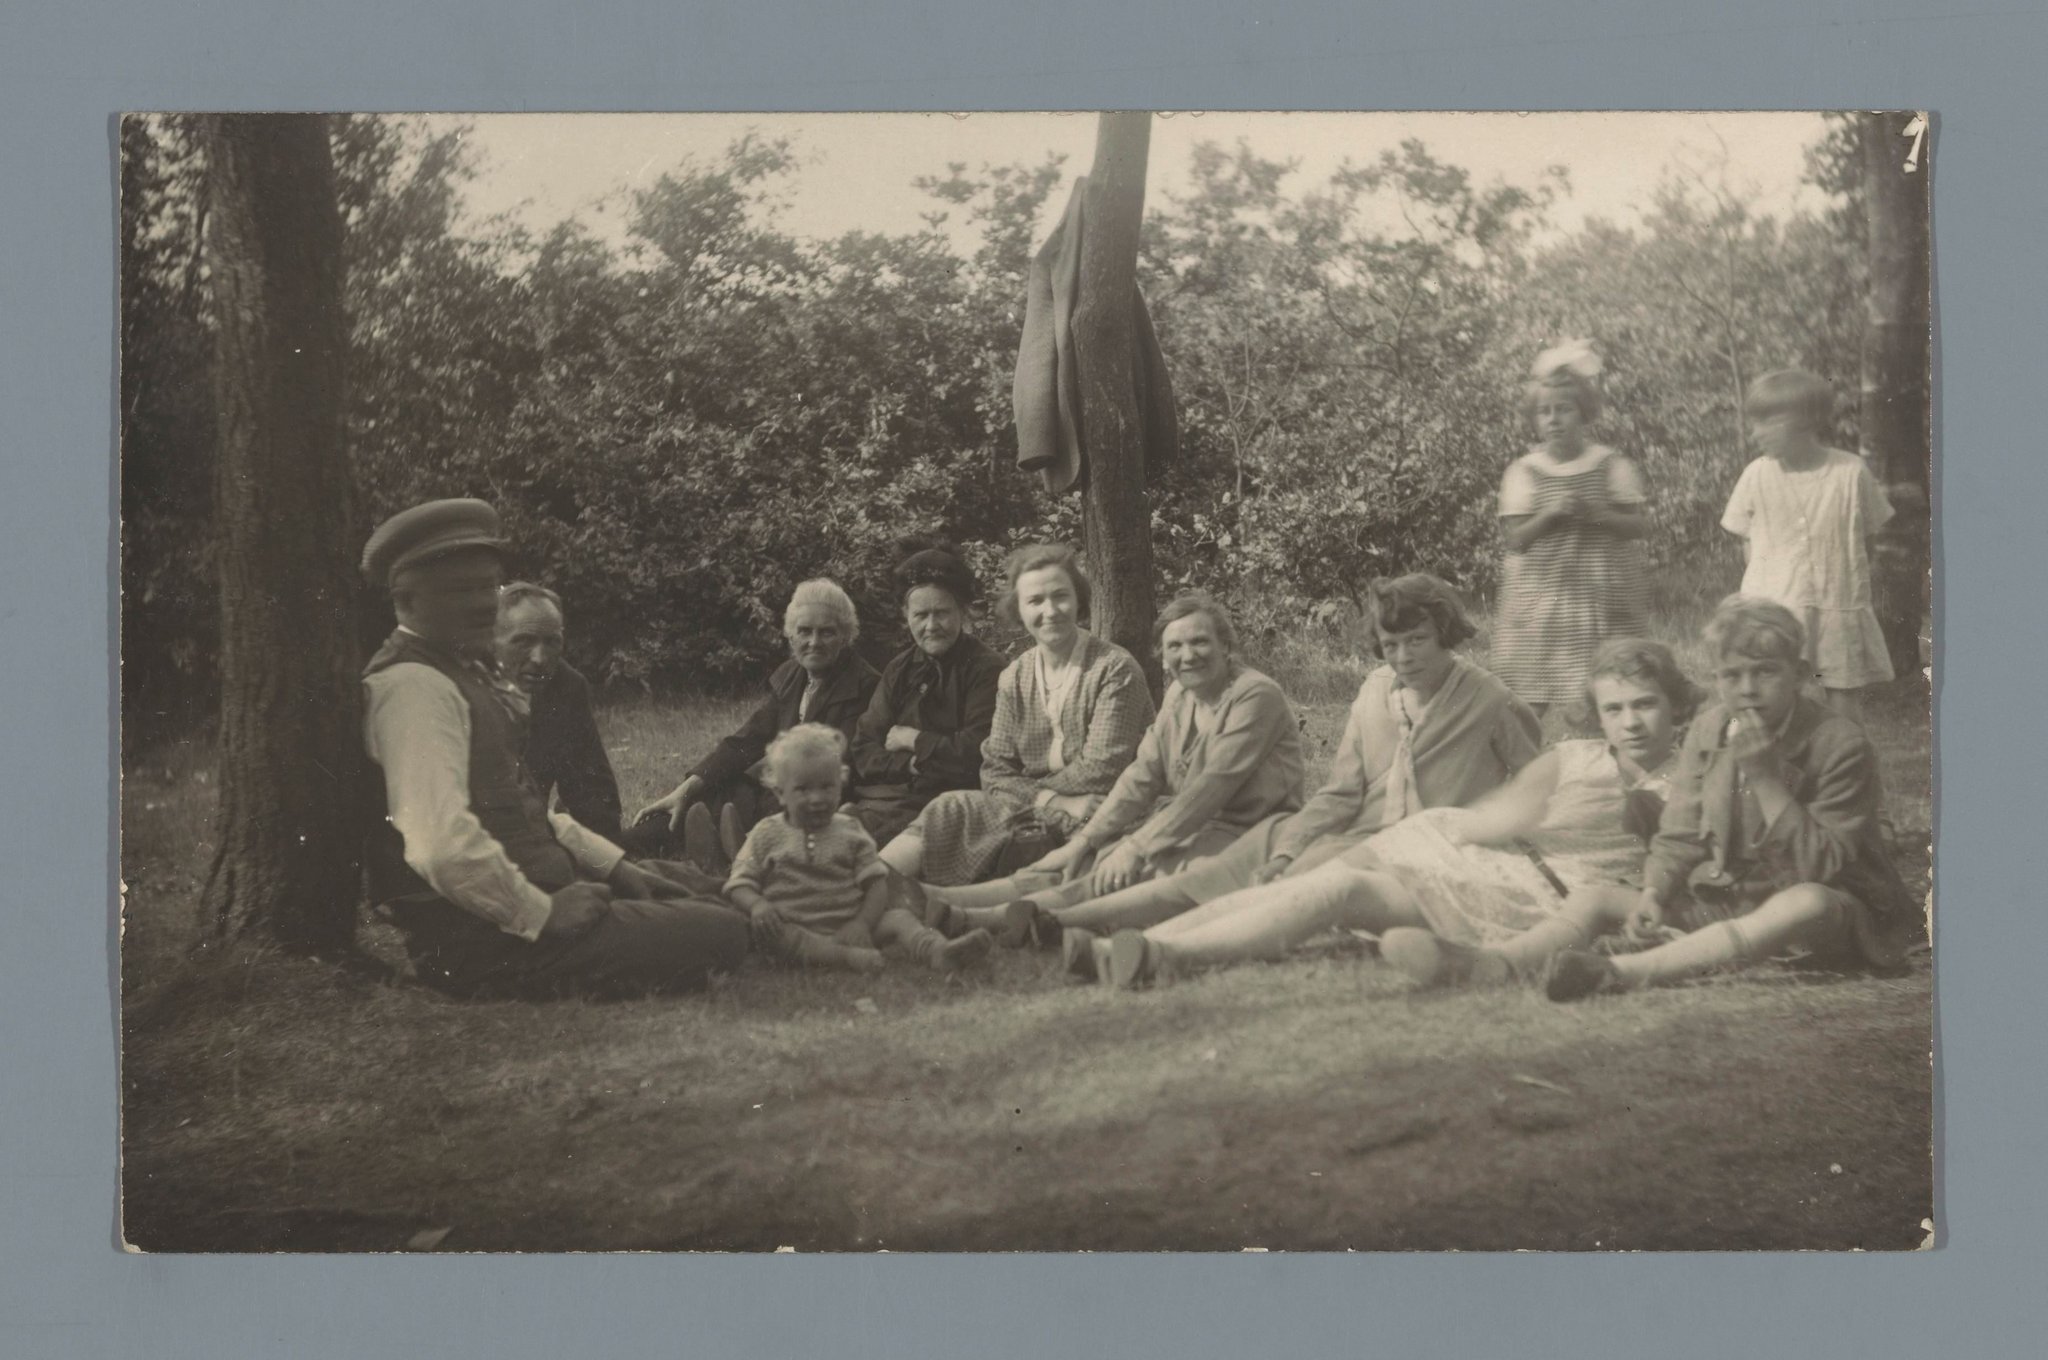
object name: ansichtkaart, prentbriefkaart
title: Zittend gezelschap (vermoedelijk) in een bos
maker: Anonymous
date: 1907-1915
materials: photographic support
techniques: gelatin silver print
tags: forest, wood, sitting on the ground, anonymous historical persons portrayed in a group, in a group-portrait